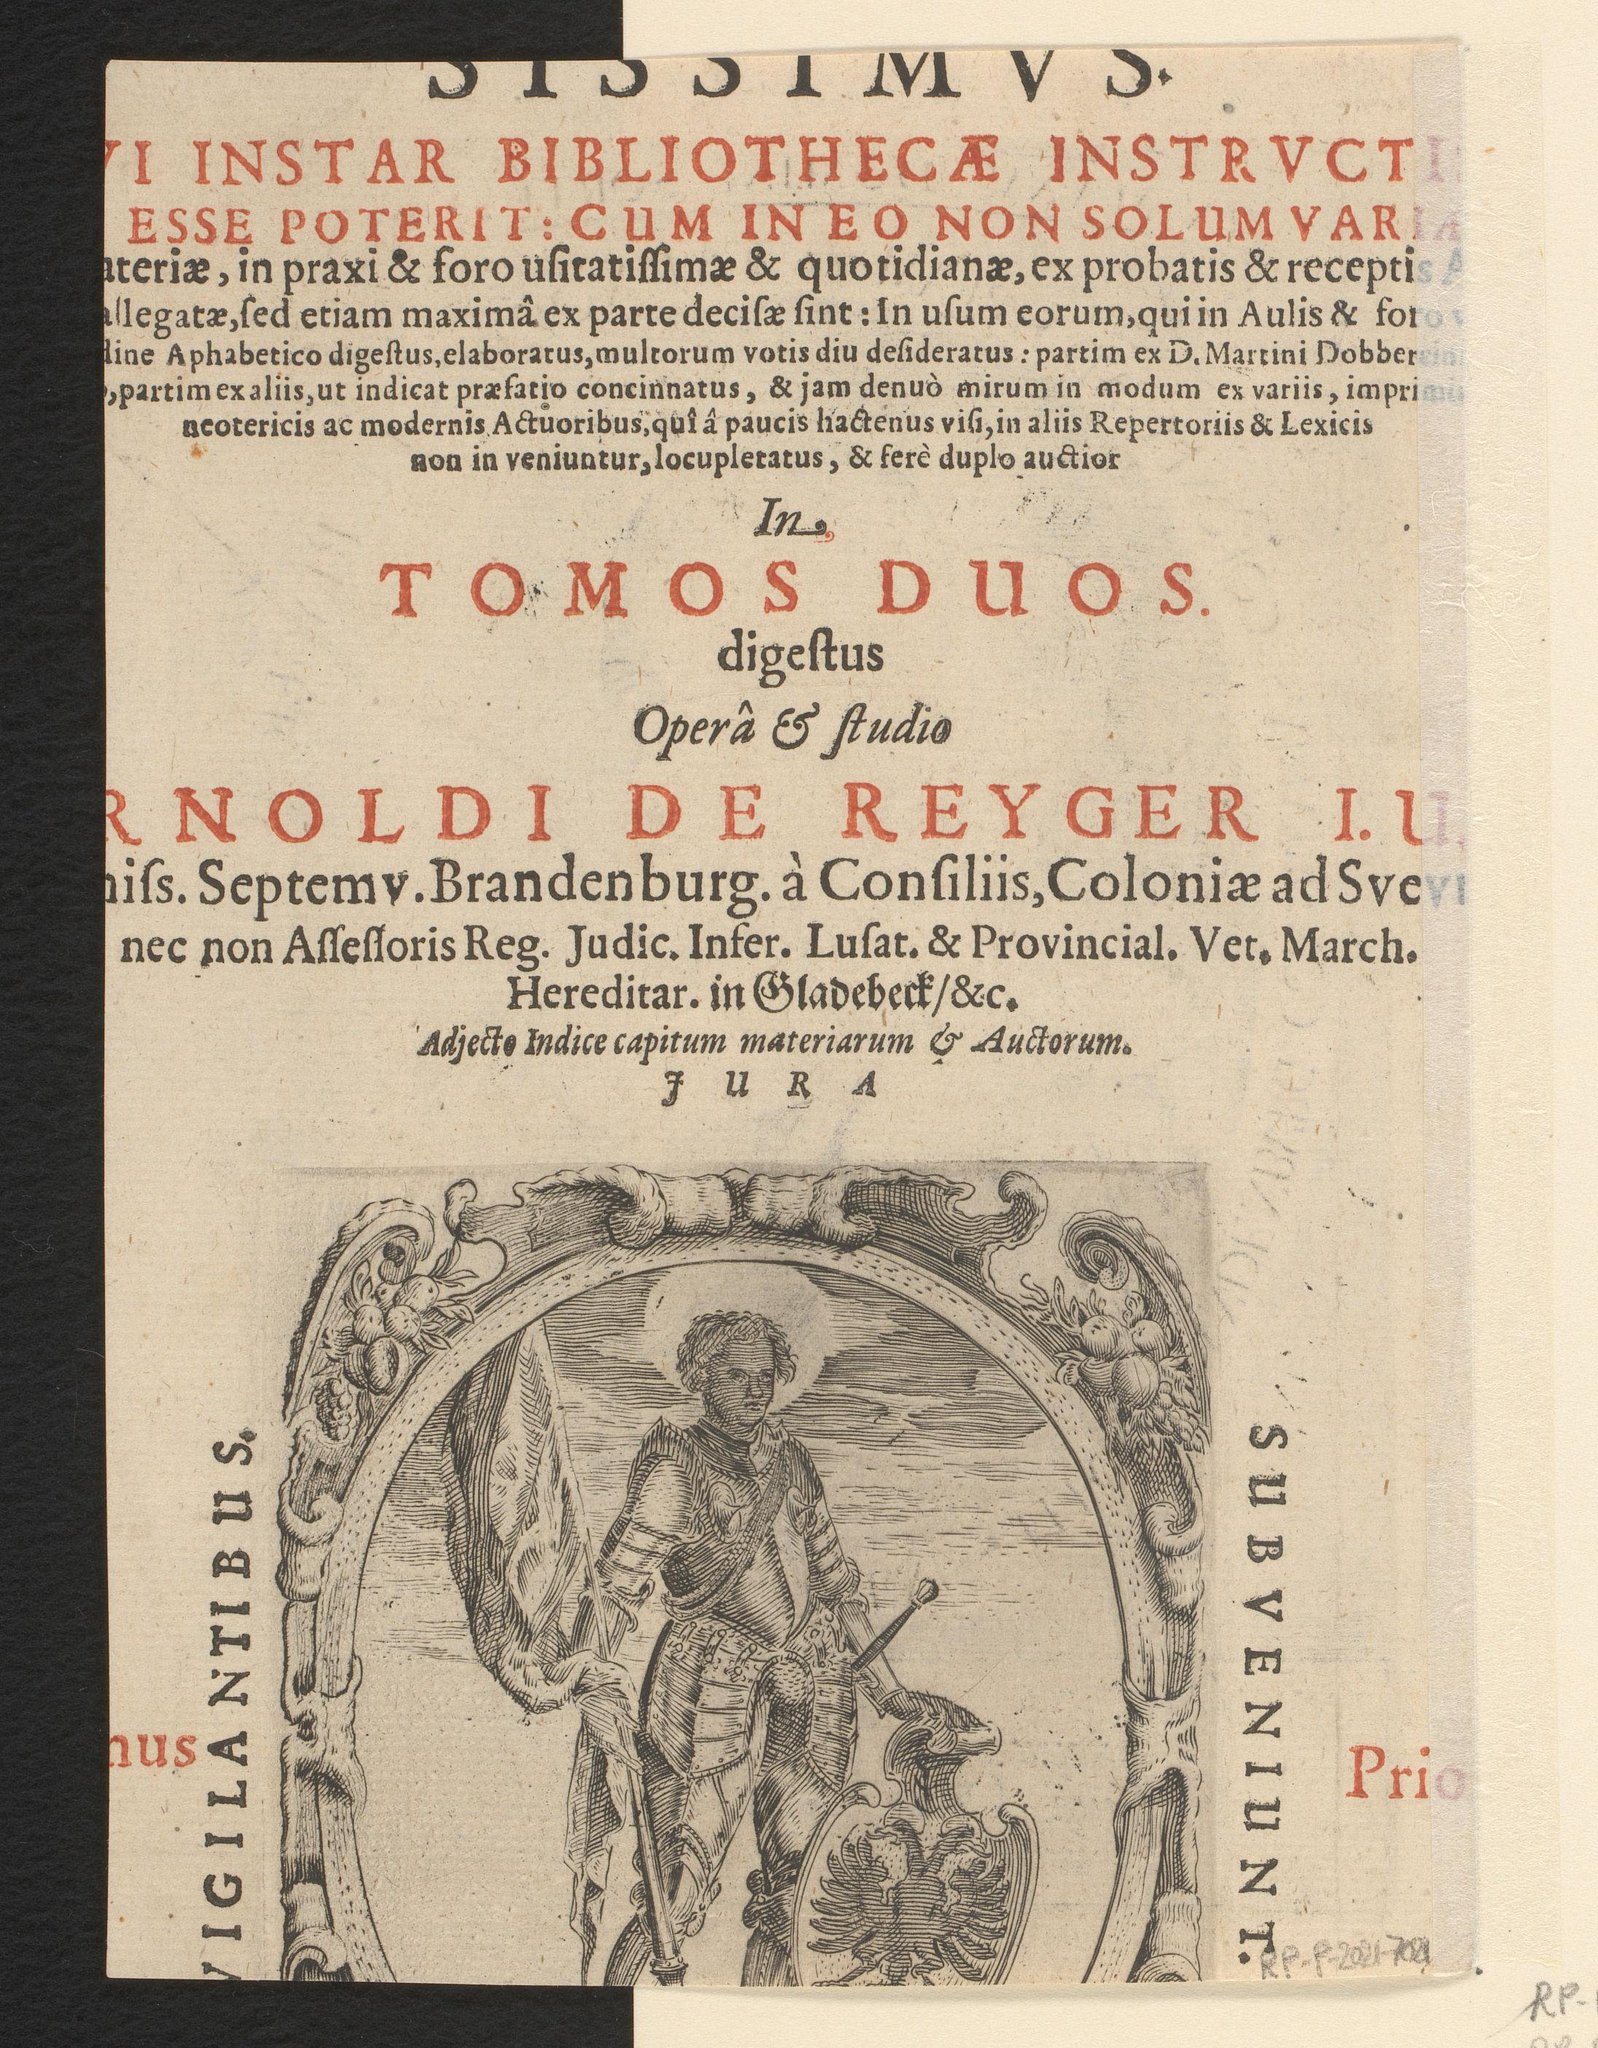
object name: print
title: Ridder met schild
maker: Anonymous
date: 1604-1617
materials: paper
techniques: engraving, letterpress printing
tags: knight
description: Titelpagina voor een onbekende editie van: Reyger, Arnold von. Thesaurus Juris locupletissimus et copiosissimus (...). dl. 2. In ieder geval meerdere malen uitgegeven tussen 1604 en 1617.